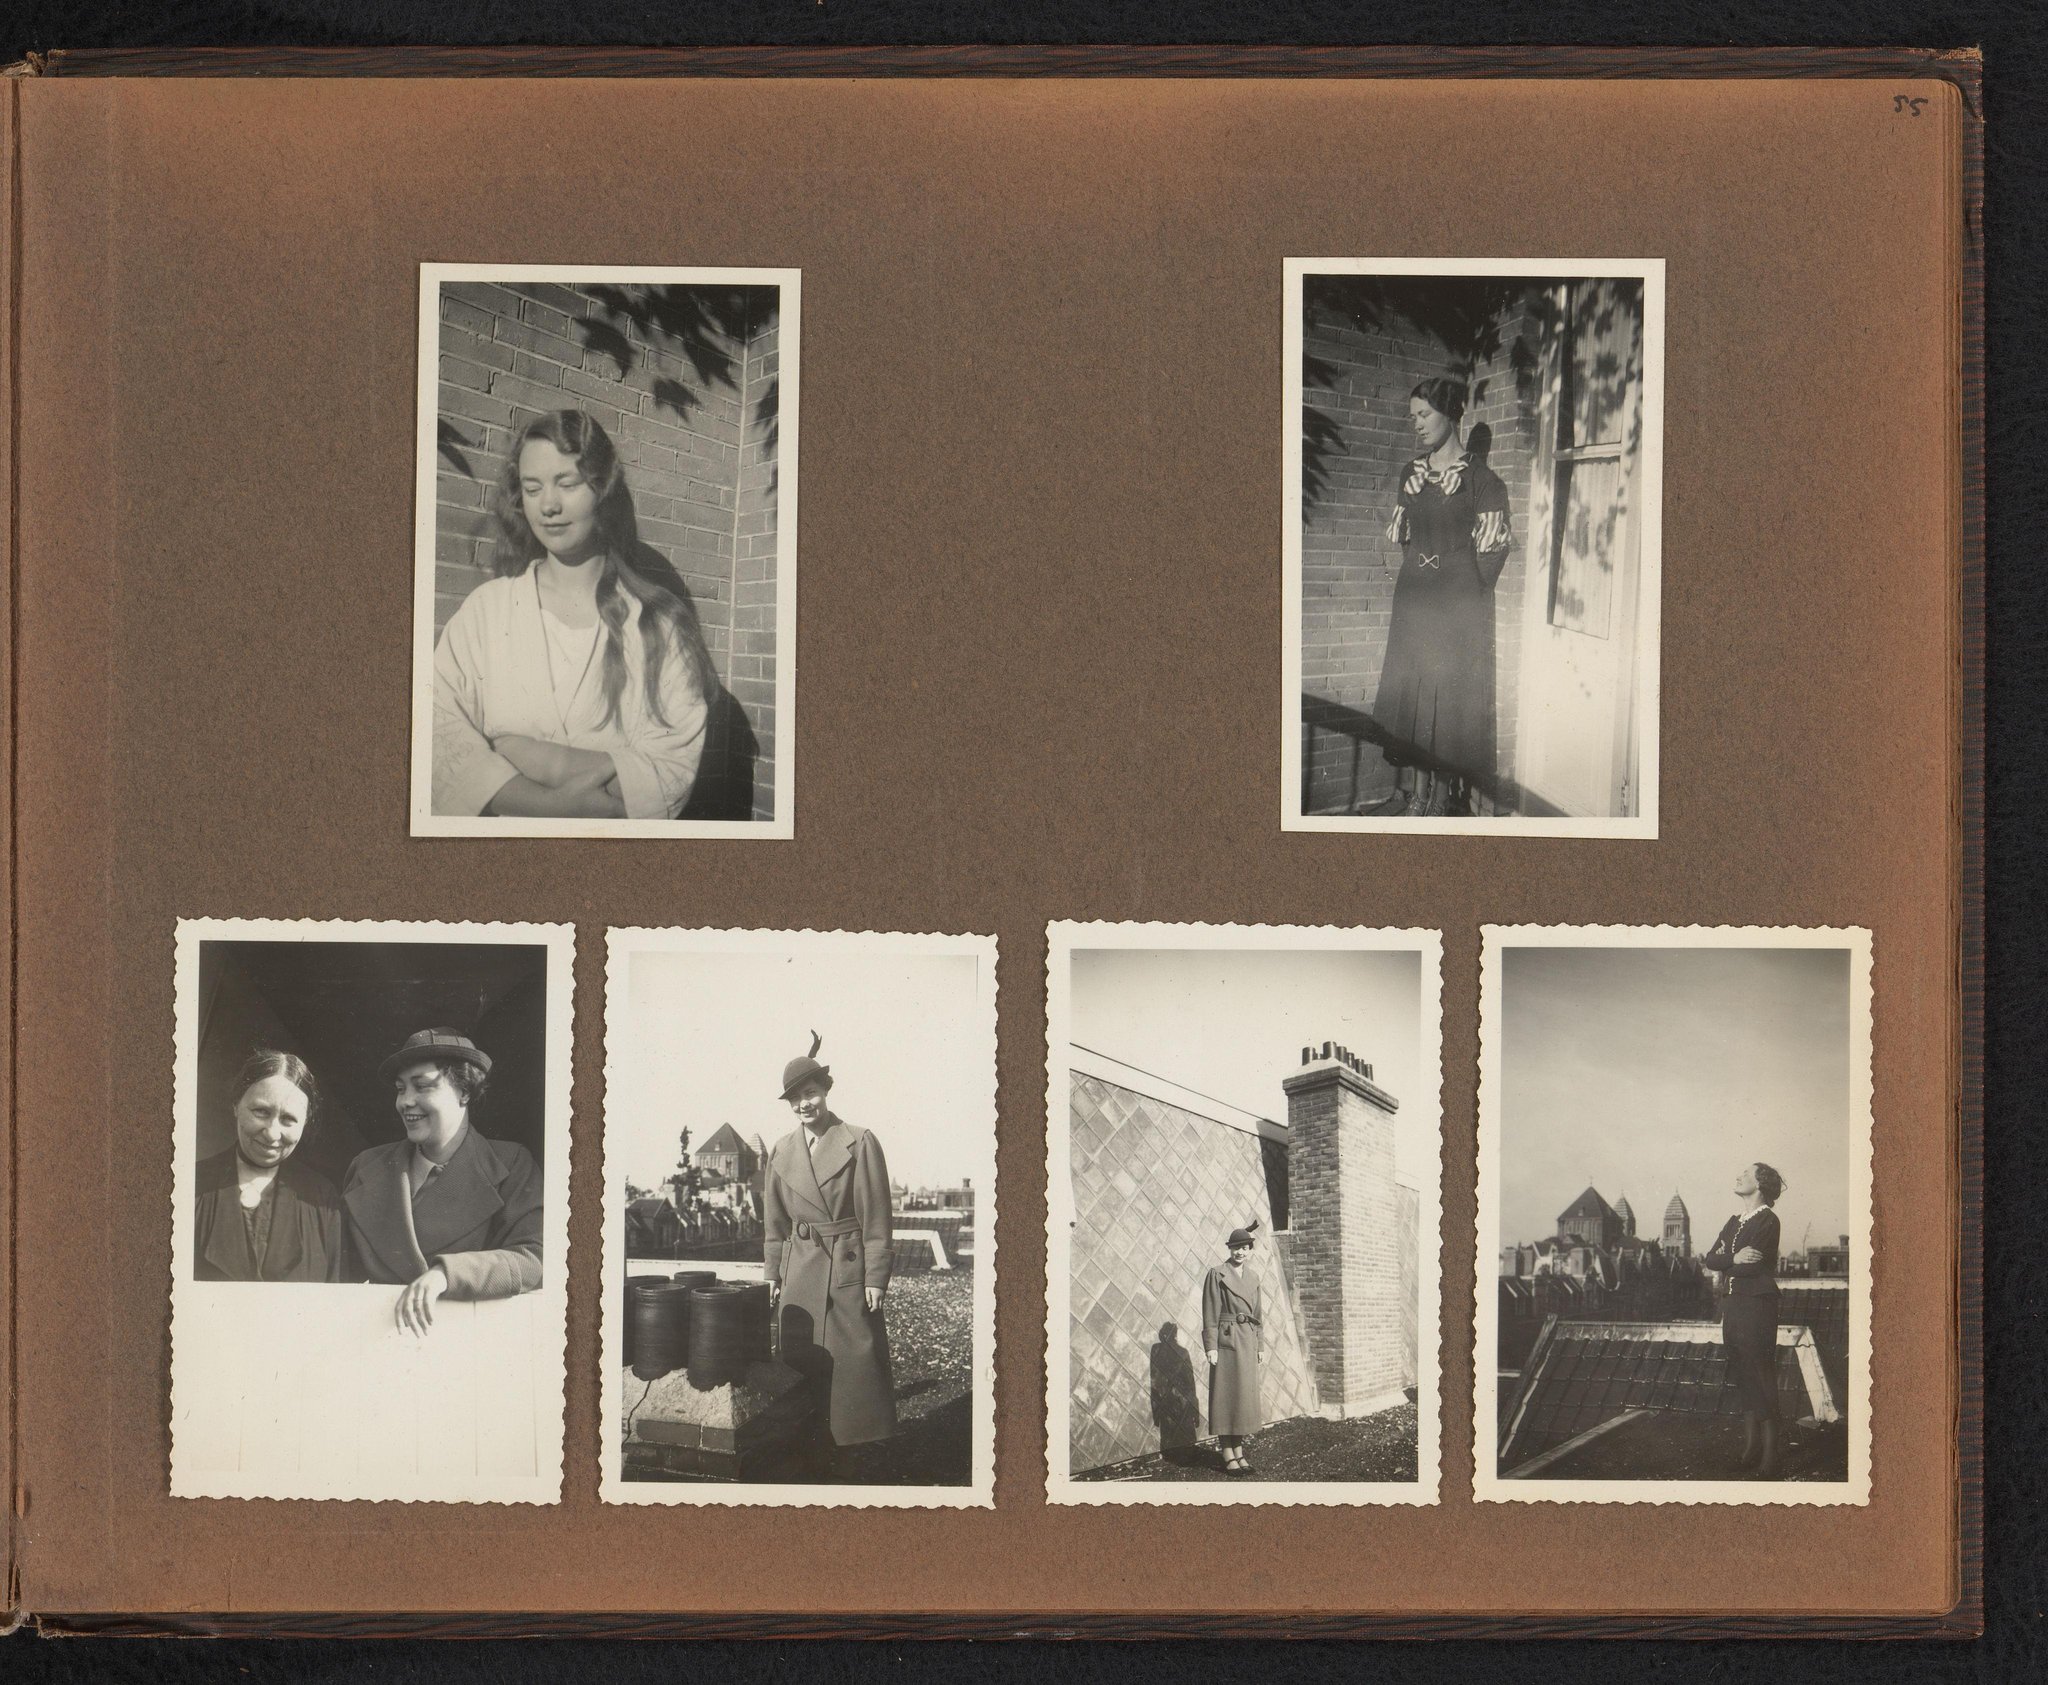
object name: photograph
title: Bladzijde uit het fotoalbum van de familie Diepenbrock met 5 foto's van Alphons Diepenbrock en zijn omgeving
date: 1909-1920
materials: cardboard, photographic support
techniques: photography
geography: amsterdam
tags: amsterdam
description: Bruin albumblad 55 van familiealbum van Alphons Diepenbrock.